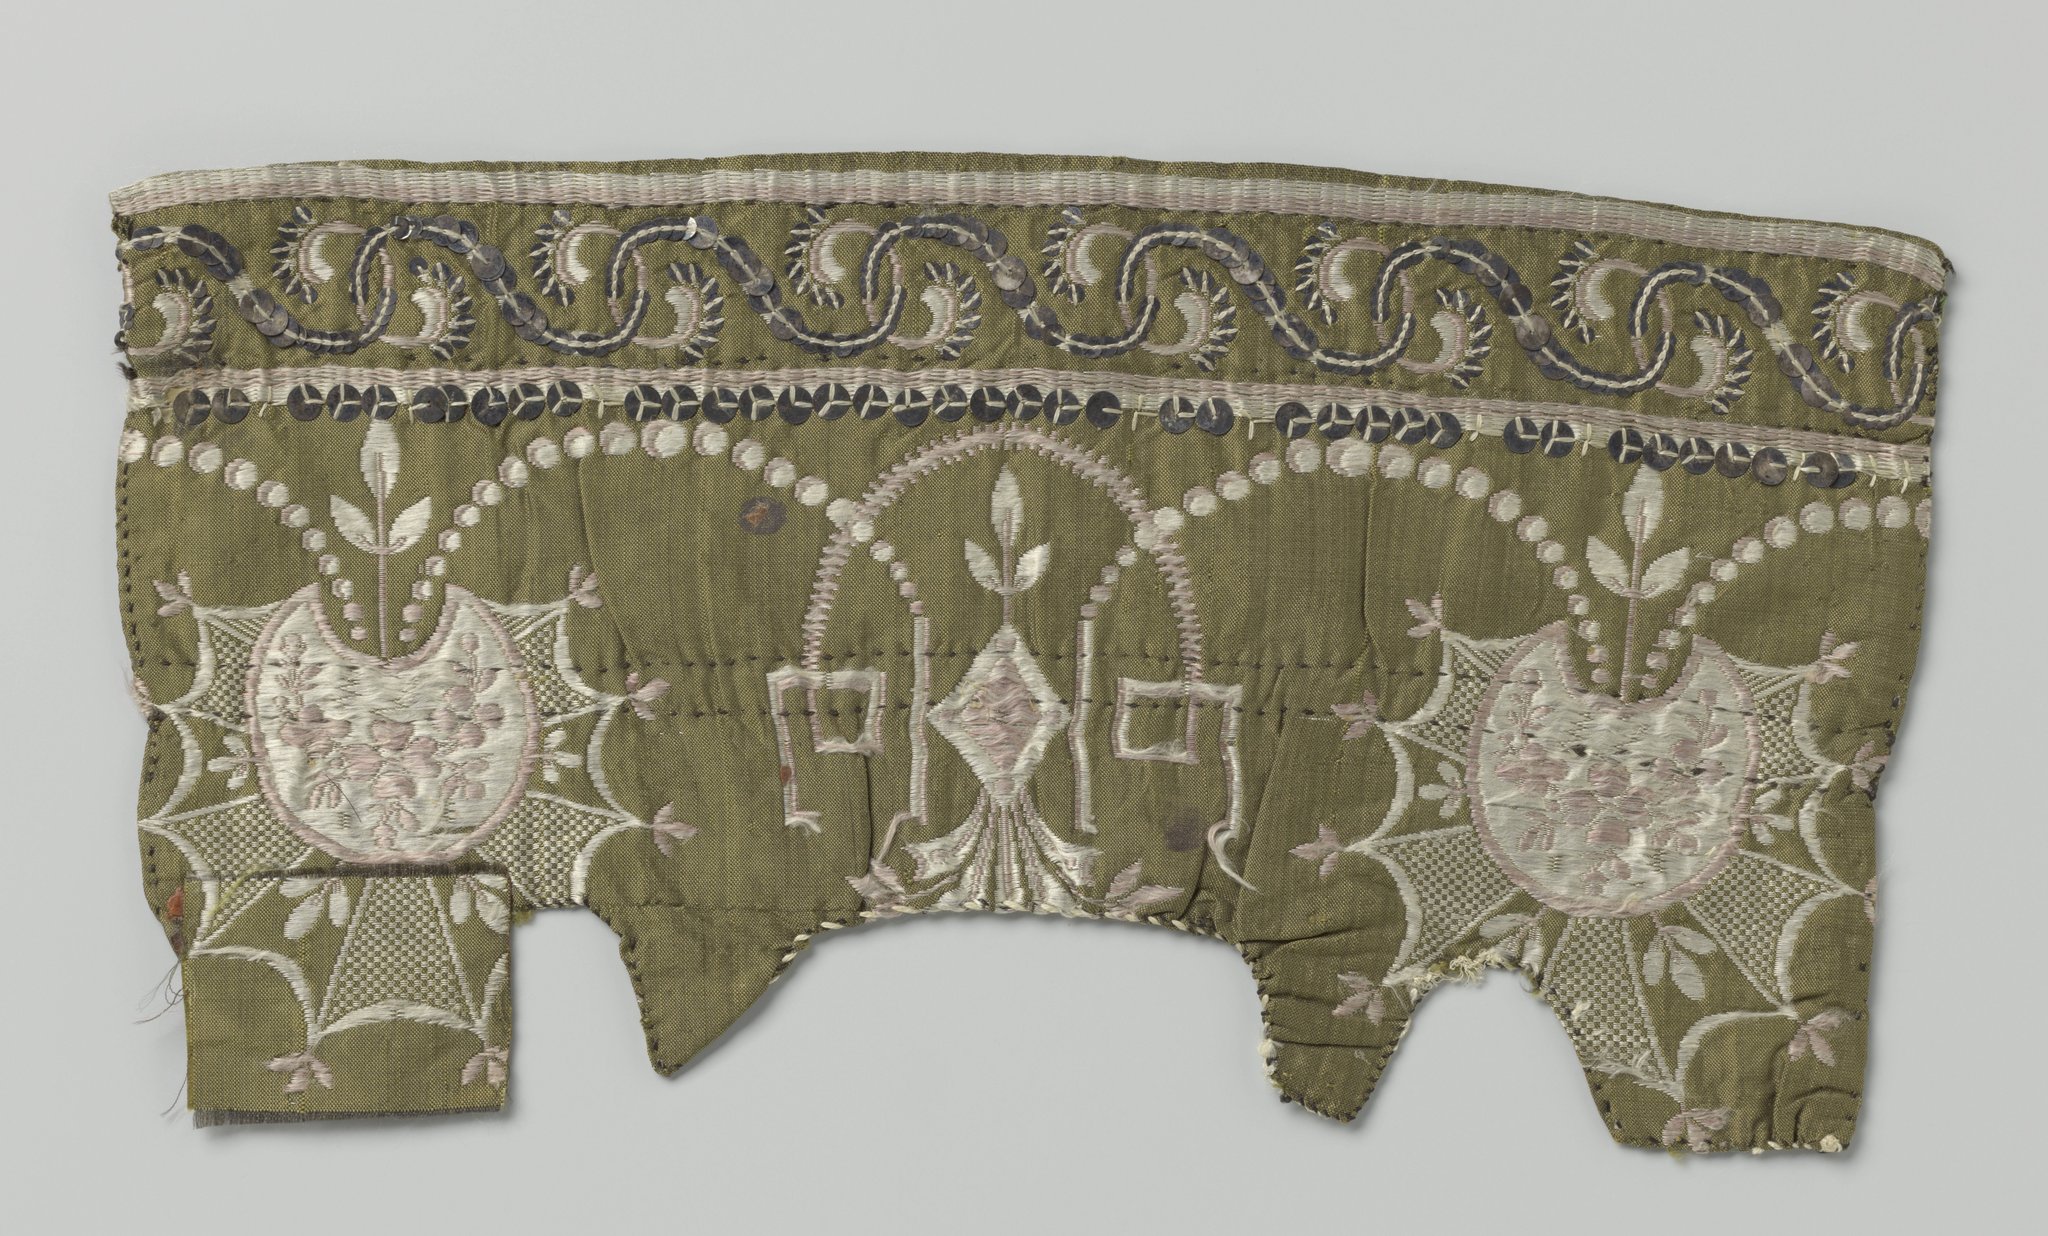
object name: fragment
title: Fragment groen zijdeweefsel met borduurwerk in roze en wit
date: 1780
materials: silk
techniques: embroidered, weave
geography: spain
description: Fragment zijdeweefsel met borduurwerk. Het borduurwerk heeft cirkels waarbinnen een bloemtak. Rond de cirkel heeft het patroon een uitwaaierend kantpatroon. De cirkel heeft een inkeping van waaruit een parelguirlande naar een palmetmotief loopt en van daar uit naar de volgende cirkel. Het fragment is langs de onderzijde afgezet met een band waarbinnen een golfmotief van zilverkleurige pailletten.